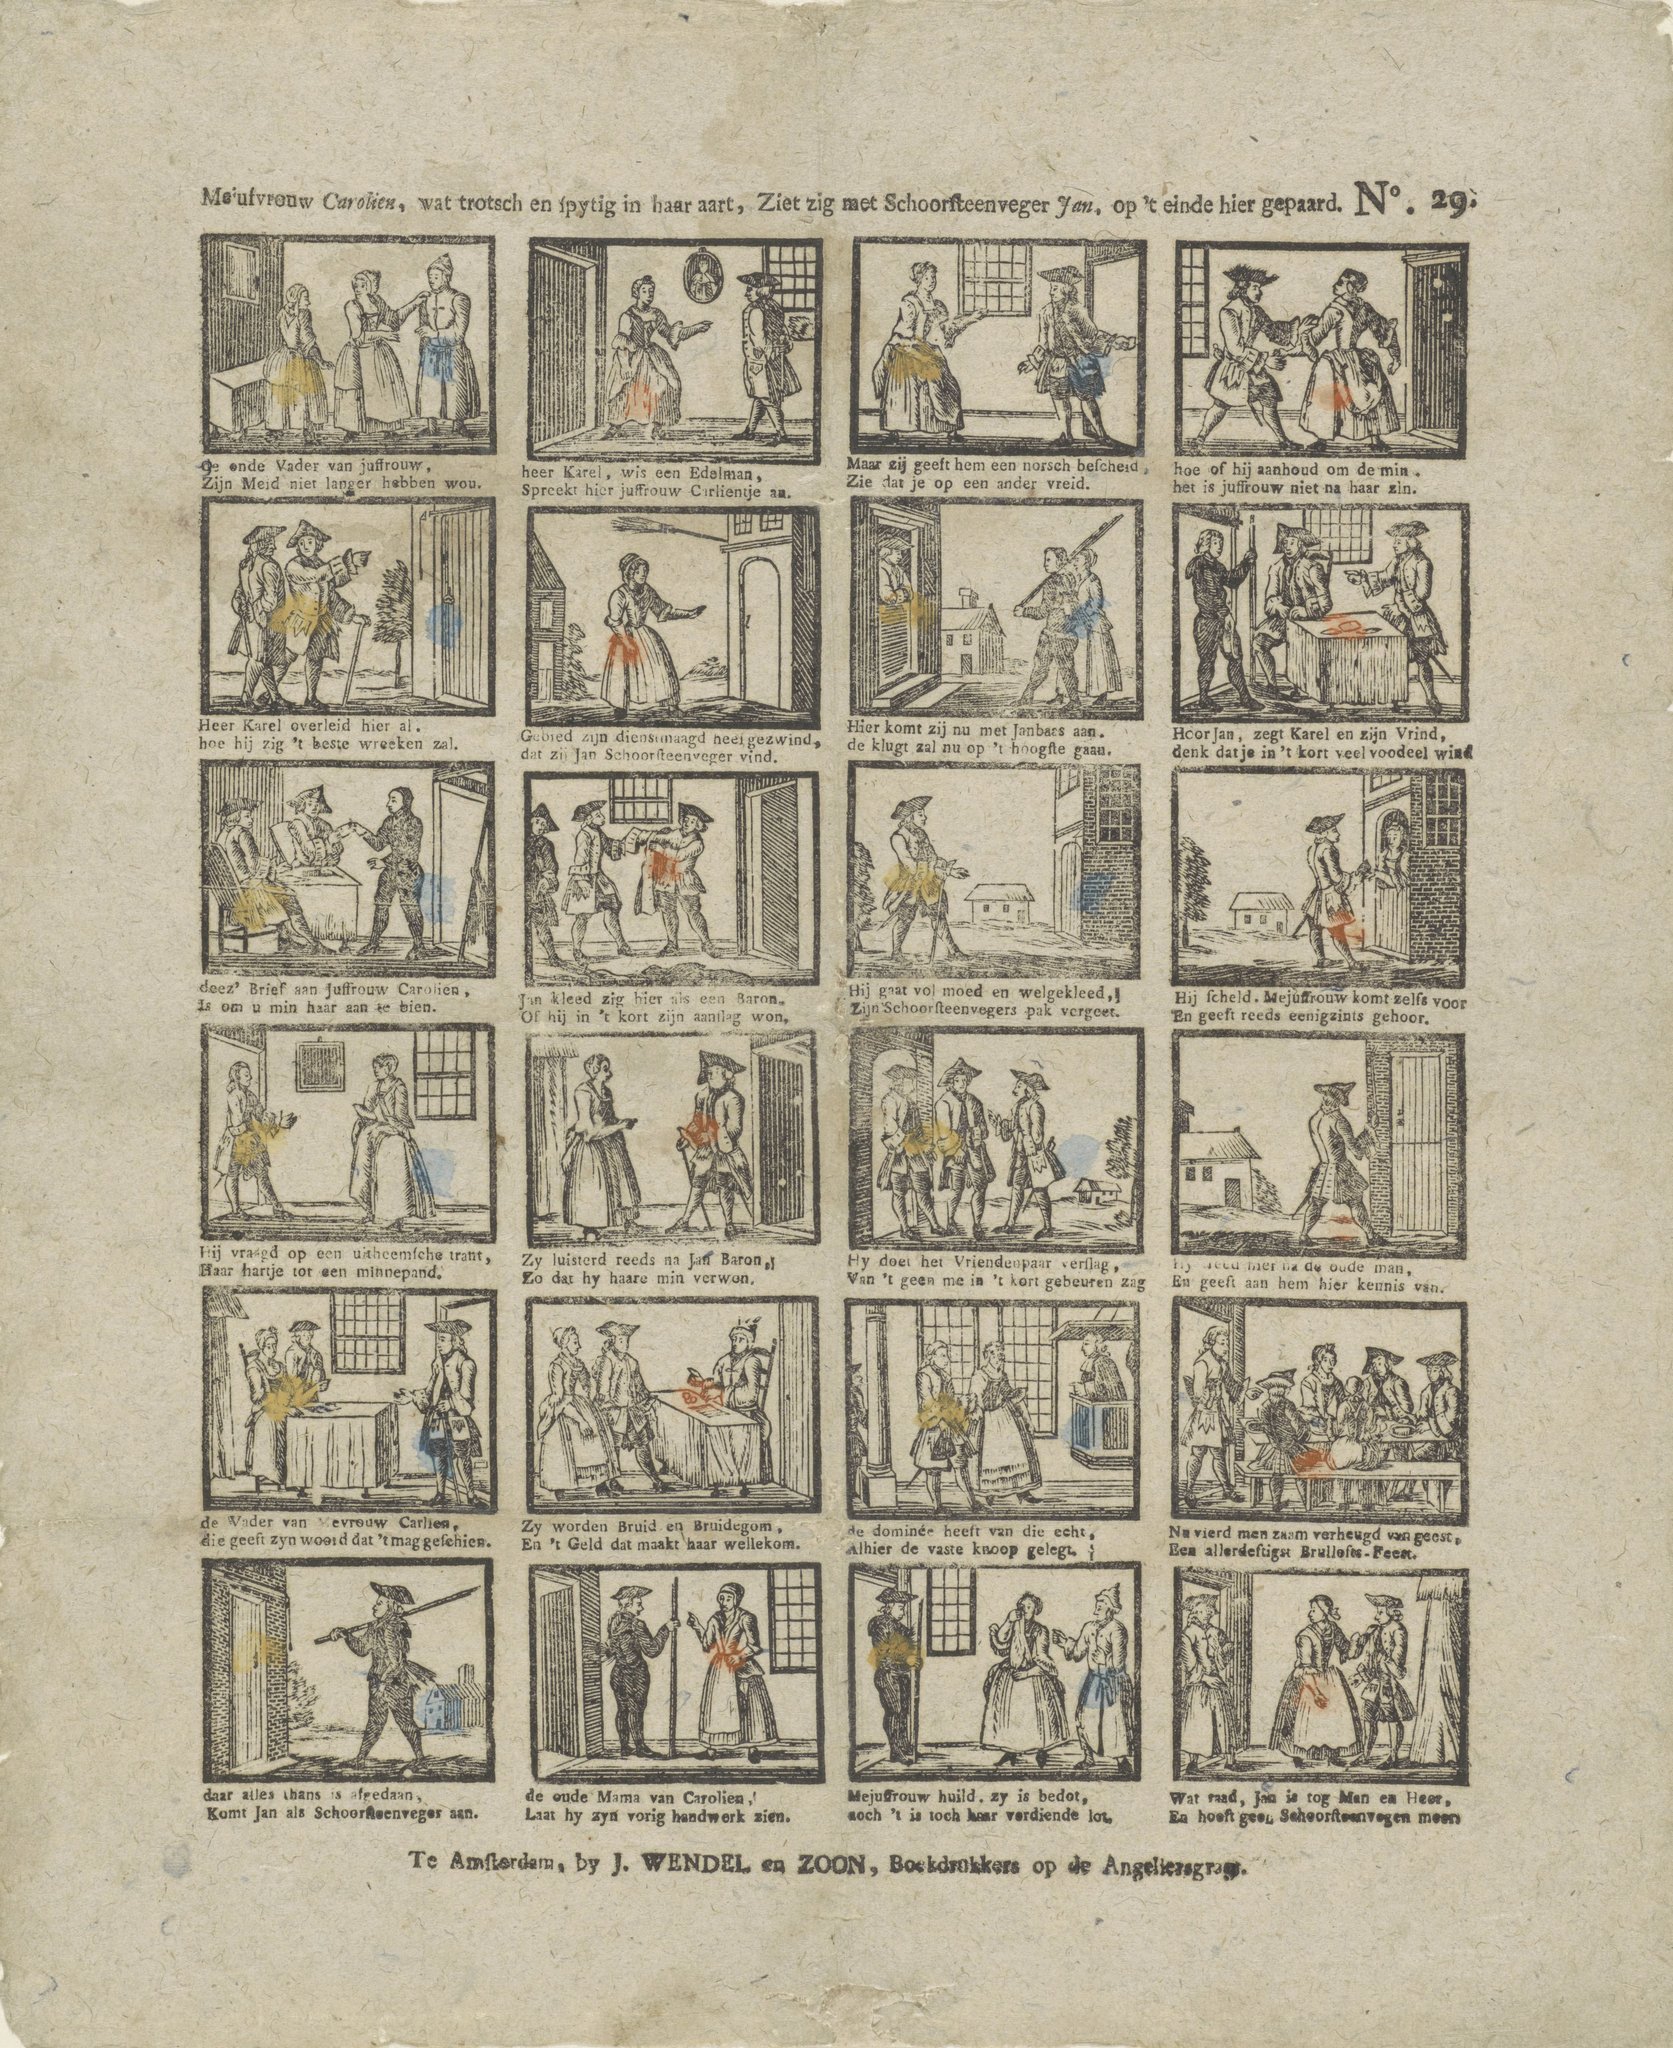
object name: print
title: Mejufvrouw Carolien, wat trotsch en spytig in haar aart, / Ziet zig met schoorsteenveger Jan, op 't einde hier gepaard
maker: Anonymous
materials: paper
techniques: colour, letterpress printing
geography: netherlands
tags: handicrafts ~ maintenance and repair (with name of trade or profession), betrothal and marriage, marriage contract, nobility and patriciate; chivalry, knighthood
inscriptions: collector's mark: Lugt 2760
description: Blad met 24 voorstellingen uit het verhaal van Carolien en schoorsteenveger Jan. Twee afgewezen minnaars van de hoogmoedige Carolien sturen haar een schoorsteenveger die zij rijk hebben uitgedost en goed van geld voorzien. Carolien wordt verliefd en trouwt de vermeende edelman, die daags na het huwelijk zich voordoet voor wat hij werkelijk is. Chrysenia schikt zich in haar lot en kleedt haar man volgens haar rang. Onder elke afbeelding een tweeregelig vers. Genummerd rechtsboven: No. 29.